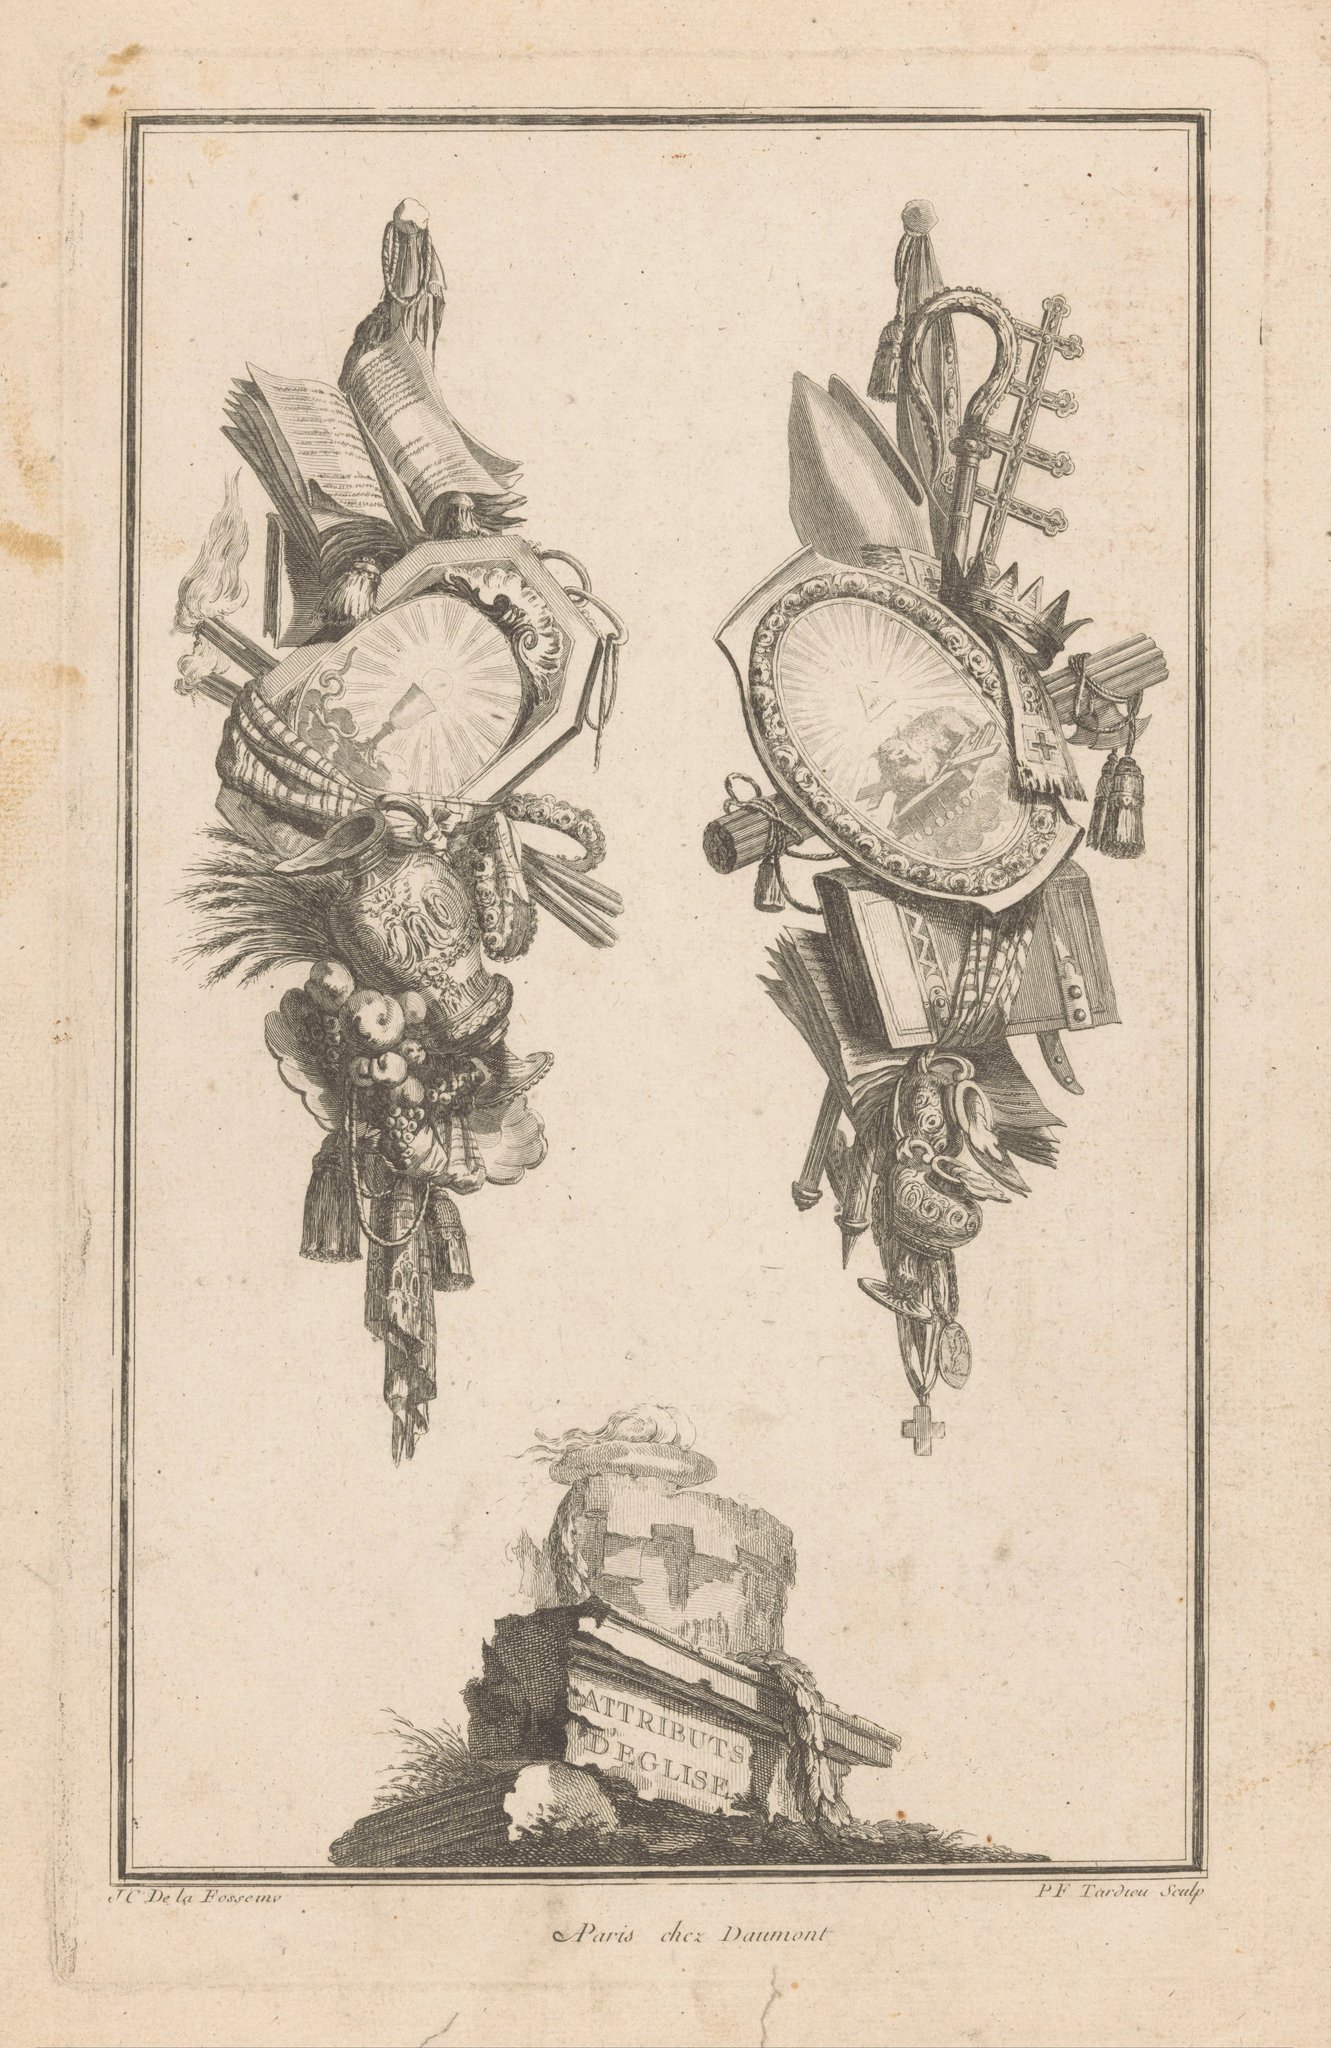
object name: ornament print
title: Trofeeën met schilden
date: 1771-1775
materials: paper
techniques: engraving, etching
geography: paris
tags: (liturgical) equipment of church, trophy, i.e.: decorative arrangement of symbolic or typical objects ~ ornament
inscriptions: collector's mark: Lugt 2228, collector's mark: Lugt 2760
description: Links een trofee met een boek, een schild met een kelk en stralenkrans, een vaas en fruit. Rechts een mijter, een staf, een kroon, een fasces, een schild met het lam op het boek met de zeven zegels, een boek en kelken.